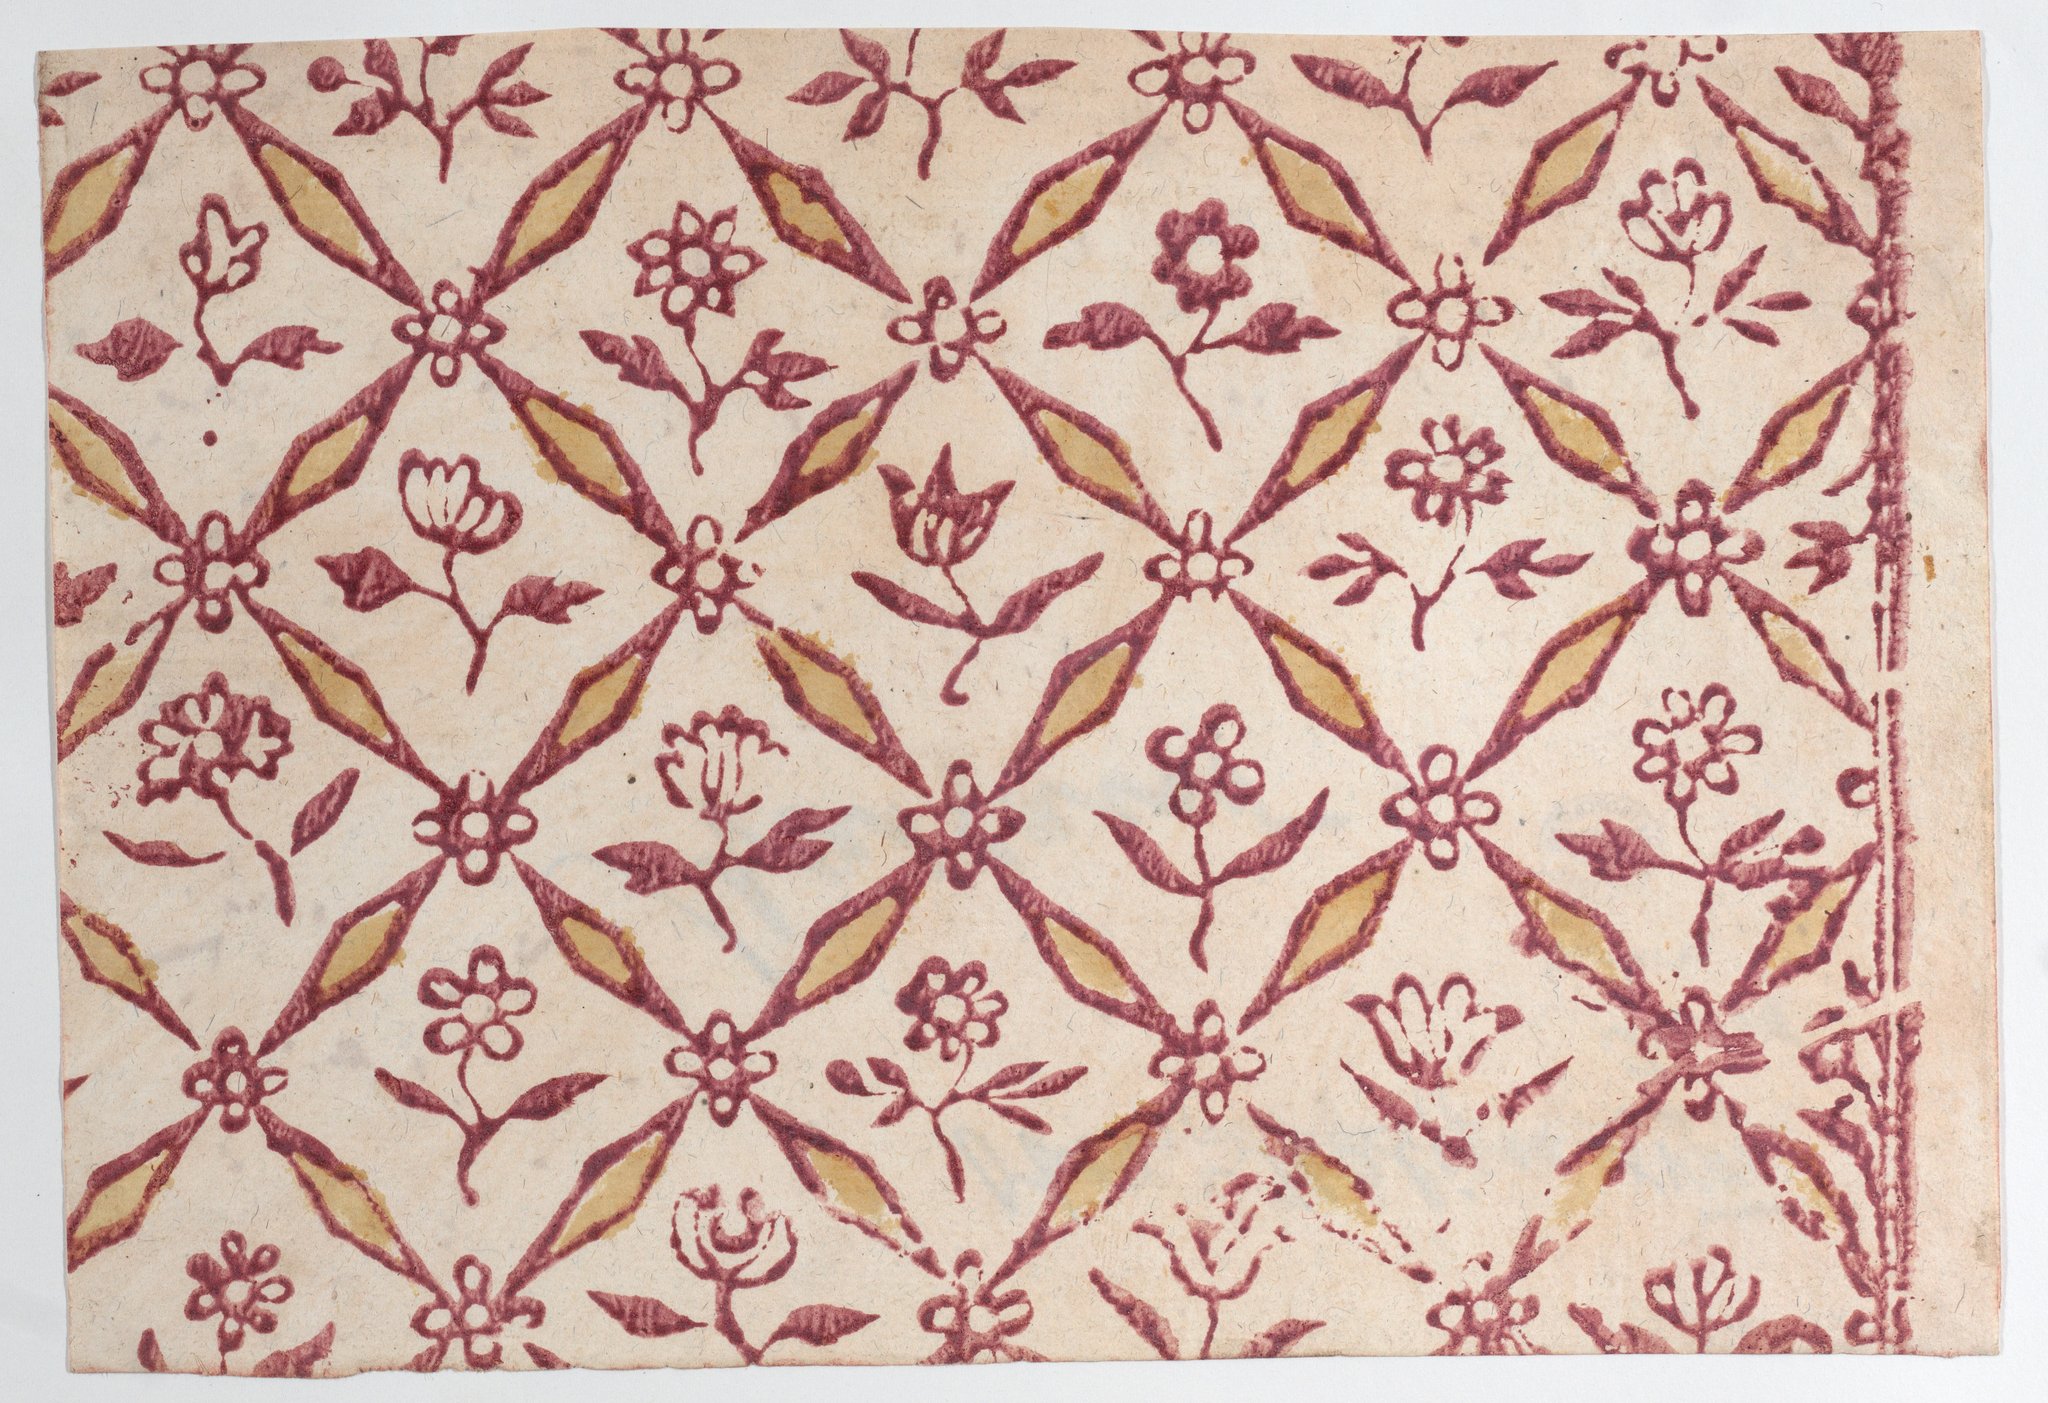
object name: print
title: Sheet with red floral pattern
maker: Anonymous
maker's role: artist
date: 1701-1800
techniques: relief print